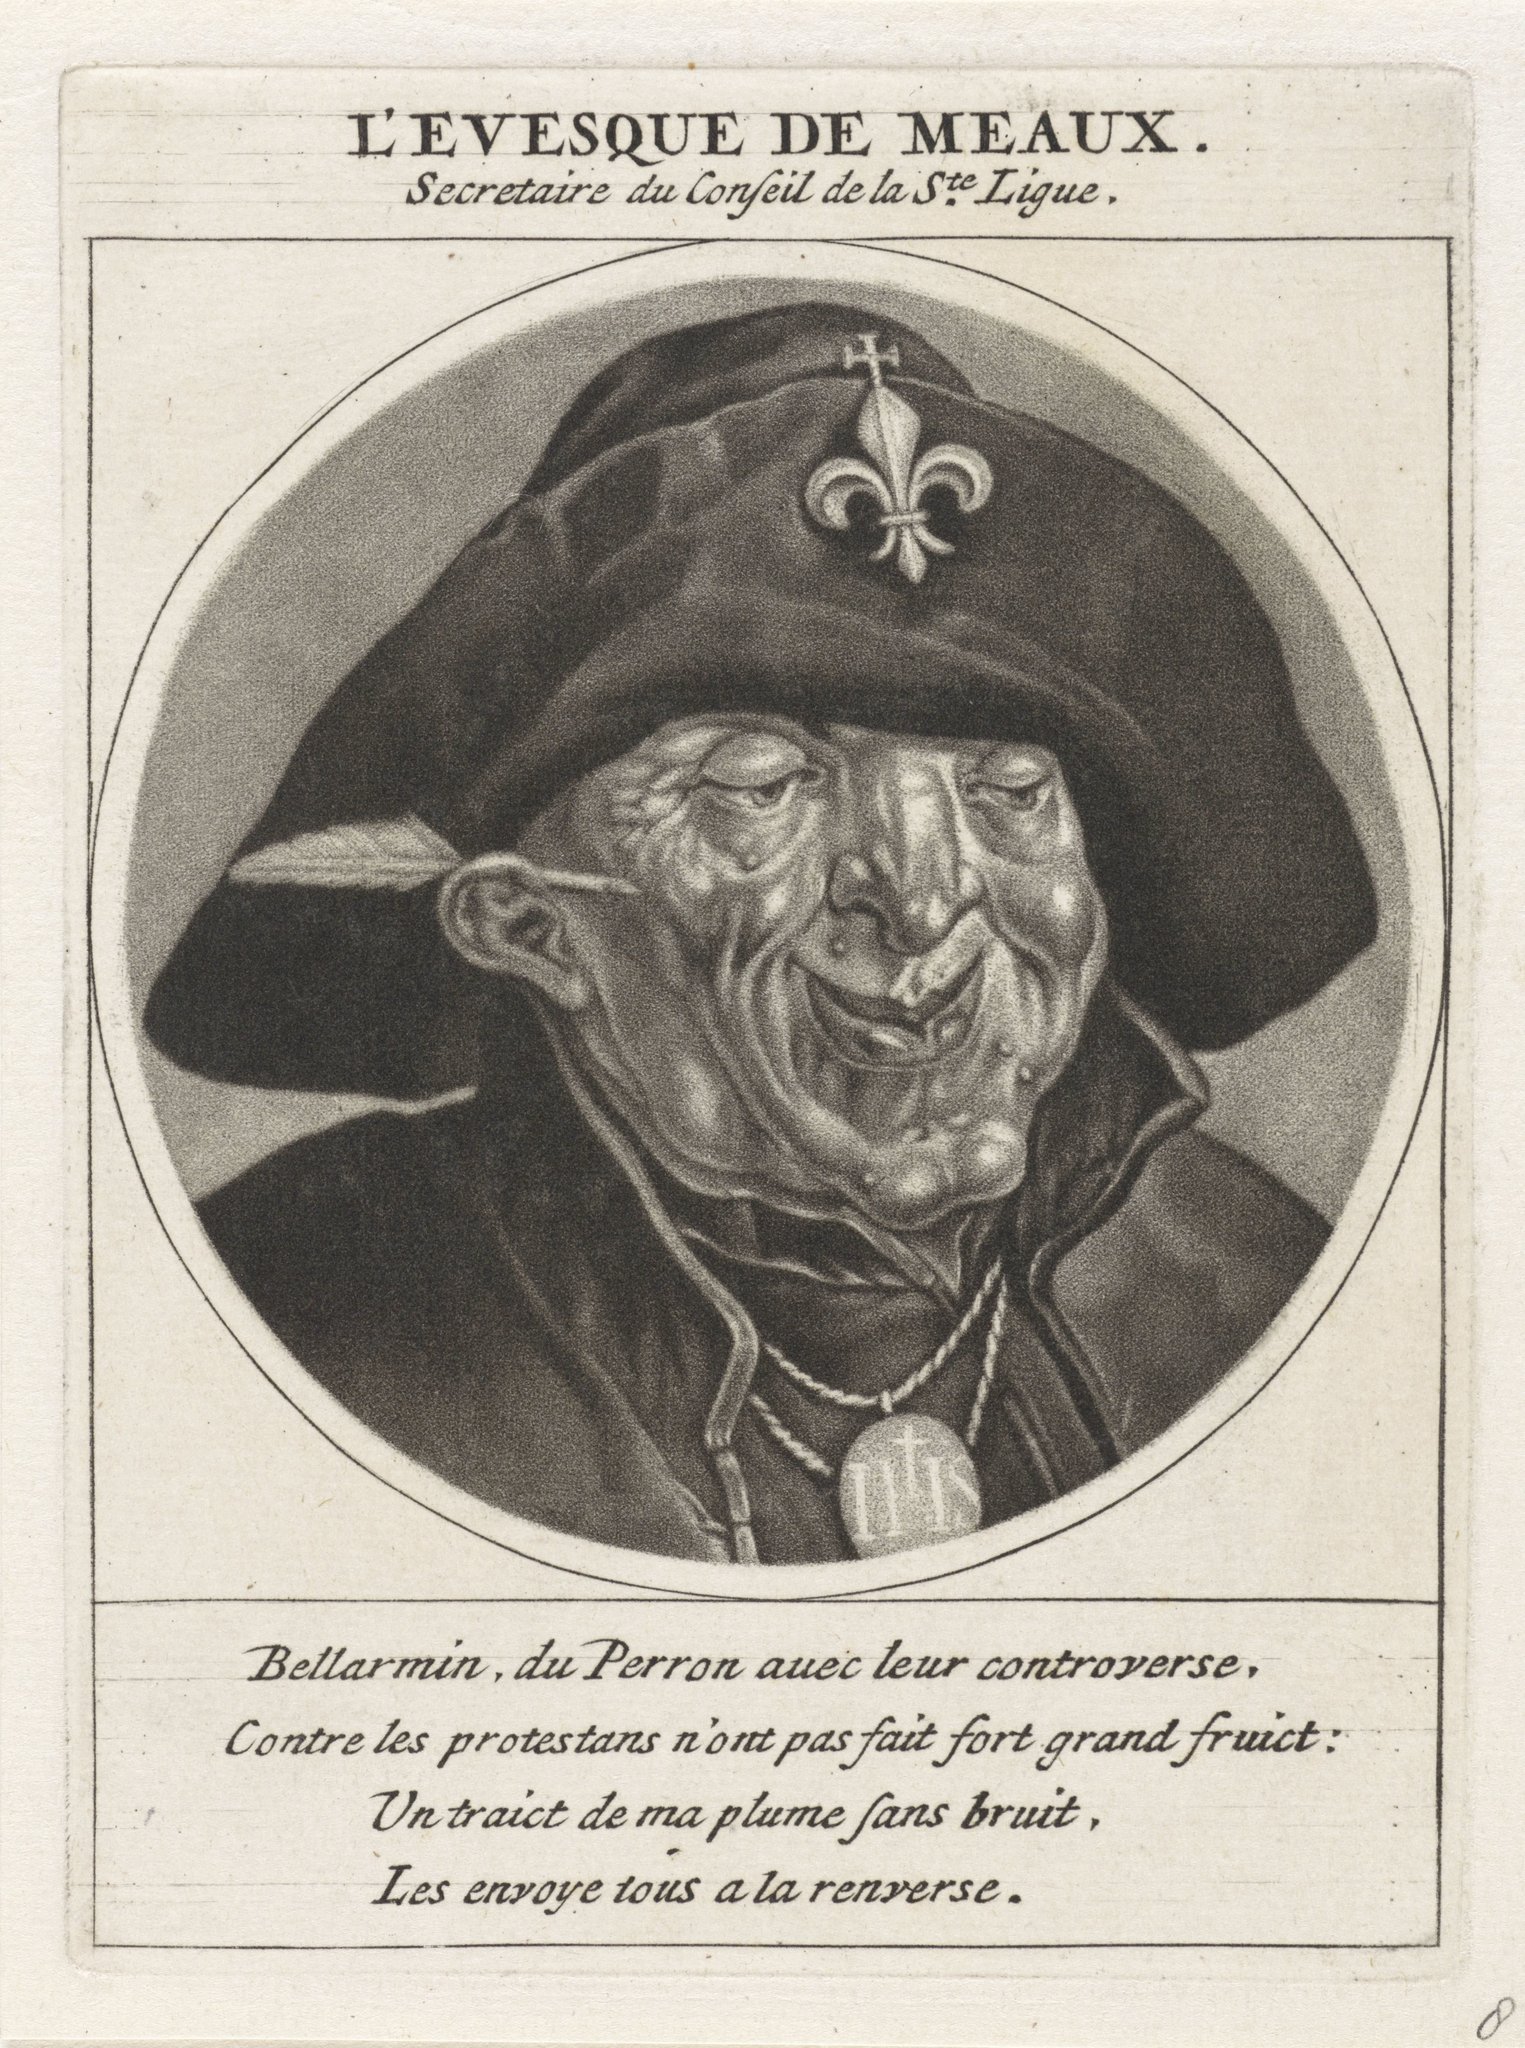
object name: print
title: Spotprenten op Lodewijk XIV en zijn gevolg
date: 1691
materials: paper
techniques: engraving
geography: paris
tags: fleur-de-lis ~ ornament, political caricatures and satires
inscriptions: collector's mark: Lugt 240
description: De bisschop van Meaux, met achter zijn oor een veer en op zijn hoed een Franse lelie. Om zijn hals een koord waaraan een medaillon met het symbool van de jezuïeten. De prent maakt deel uit van een serie met spotprenten op Lodewijk XIV en zijn gevolg.